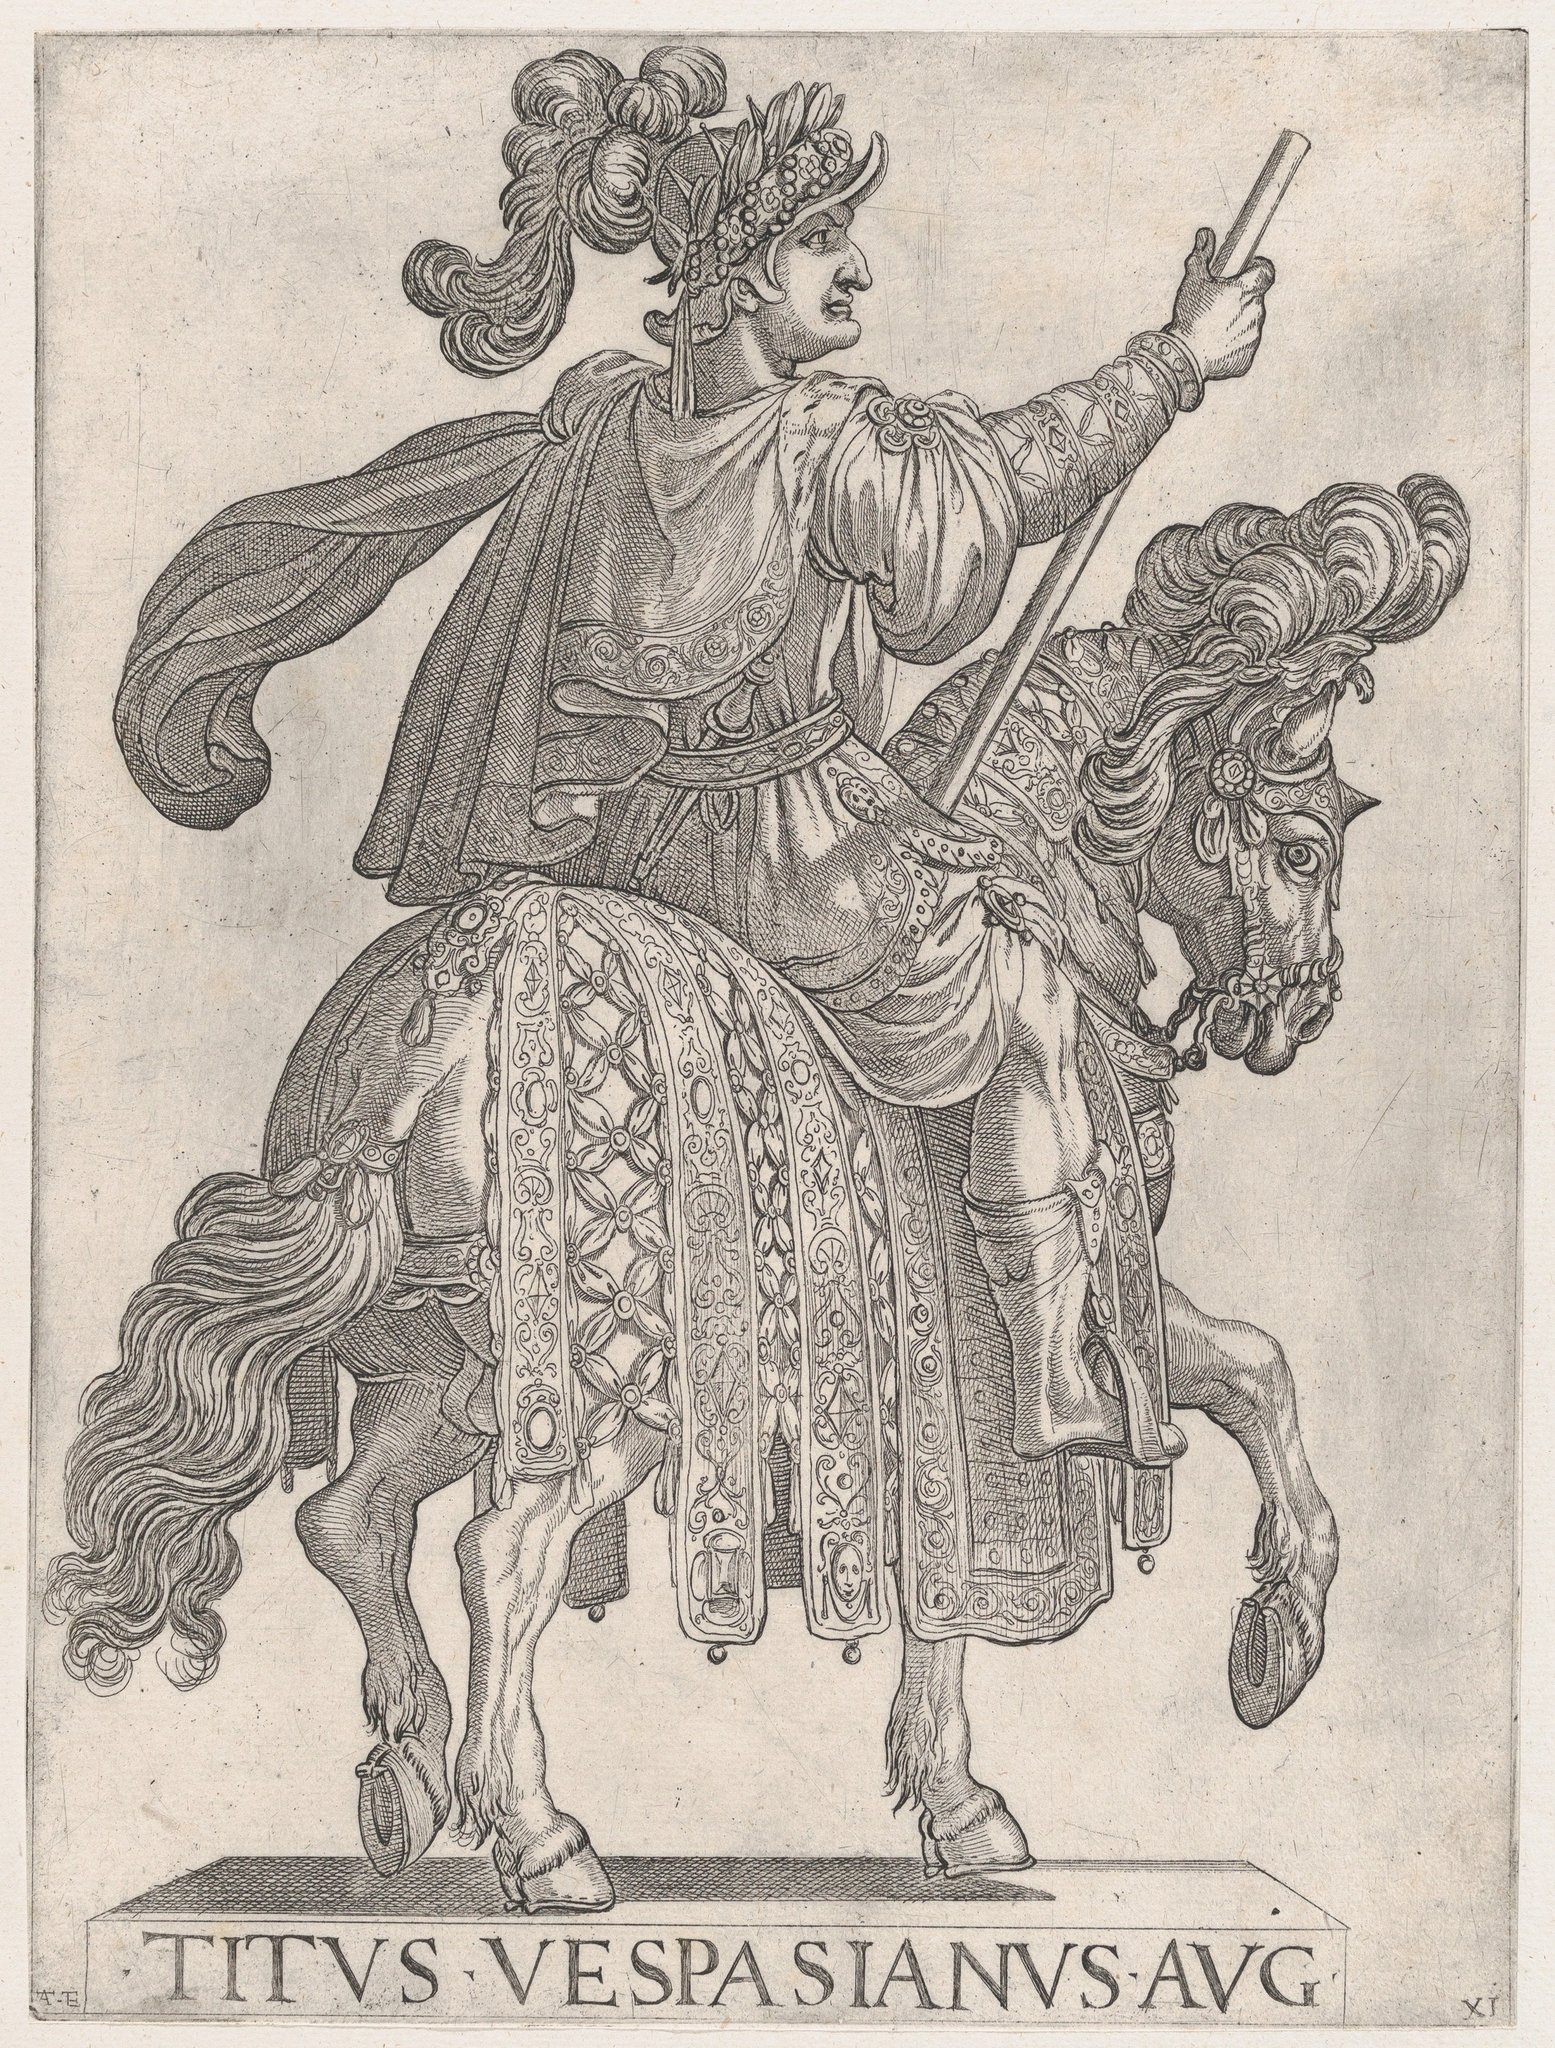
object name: print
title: Plate 11: Titus Vespasian on horseback facing right from the 'First Twelve Emperors of Ancient Rome'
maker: antonio tempesta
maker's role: artist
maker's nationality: italian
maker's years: 1555-1630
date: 1575-1630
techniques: etching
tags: men,horses